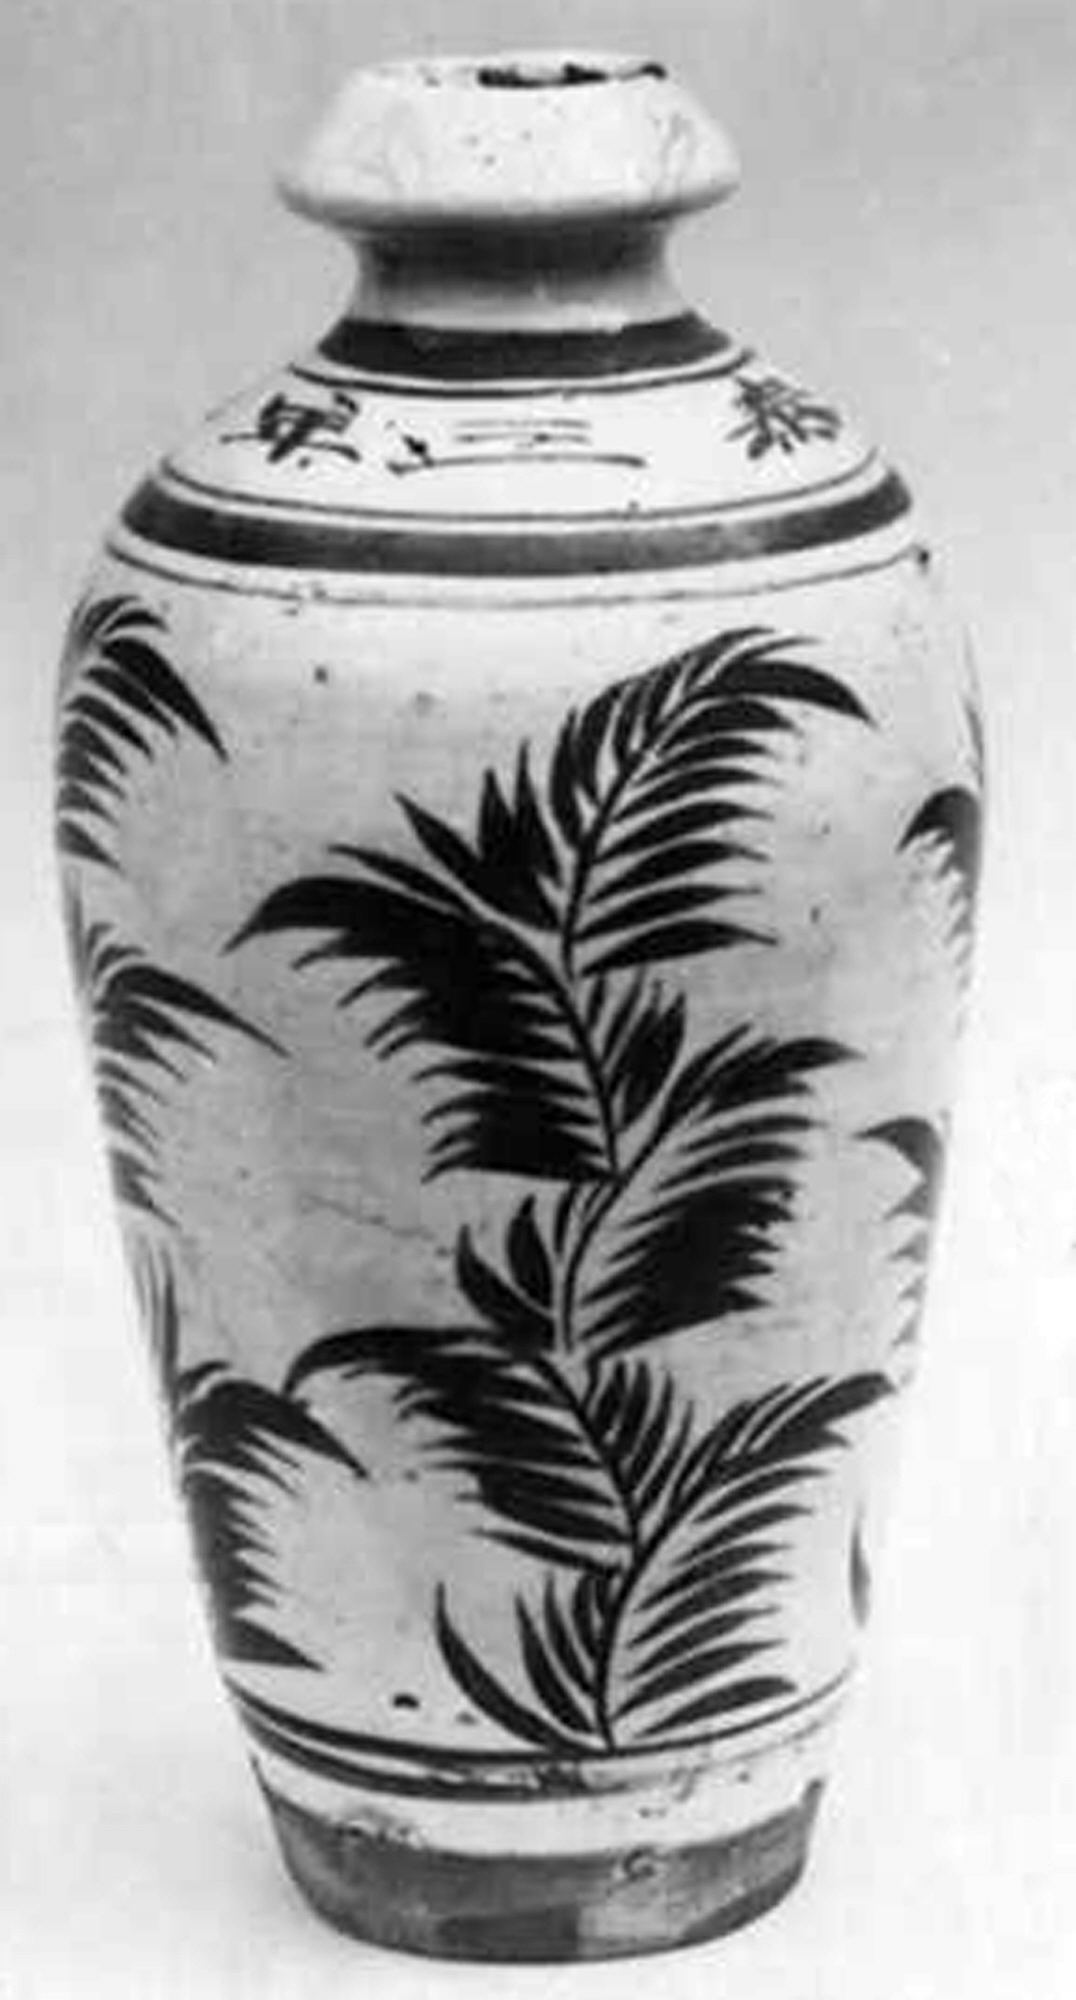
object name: vase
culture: chinese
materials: stoneware